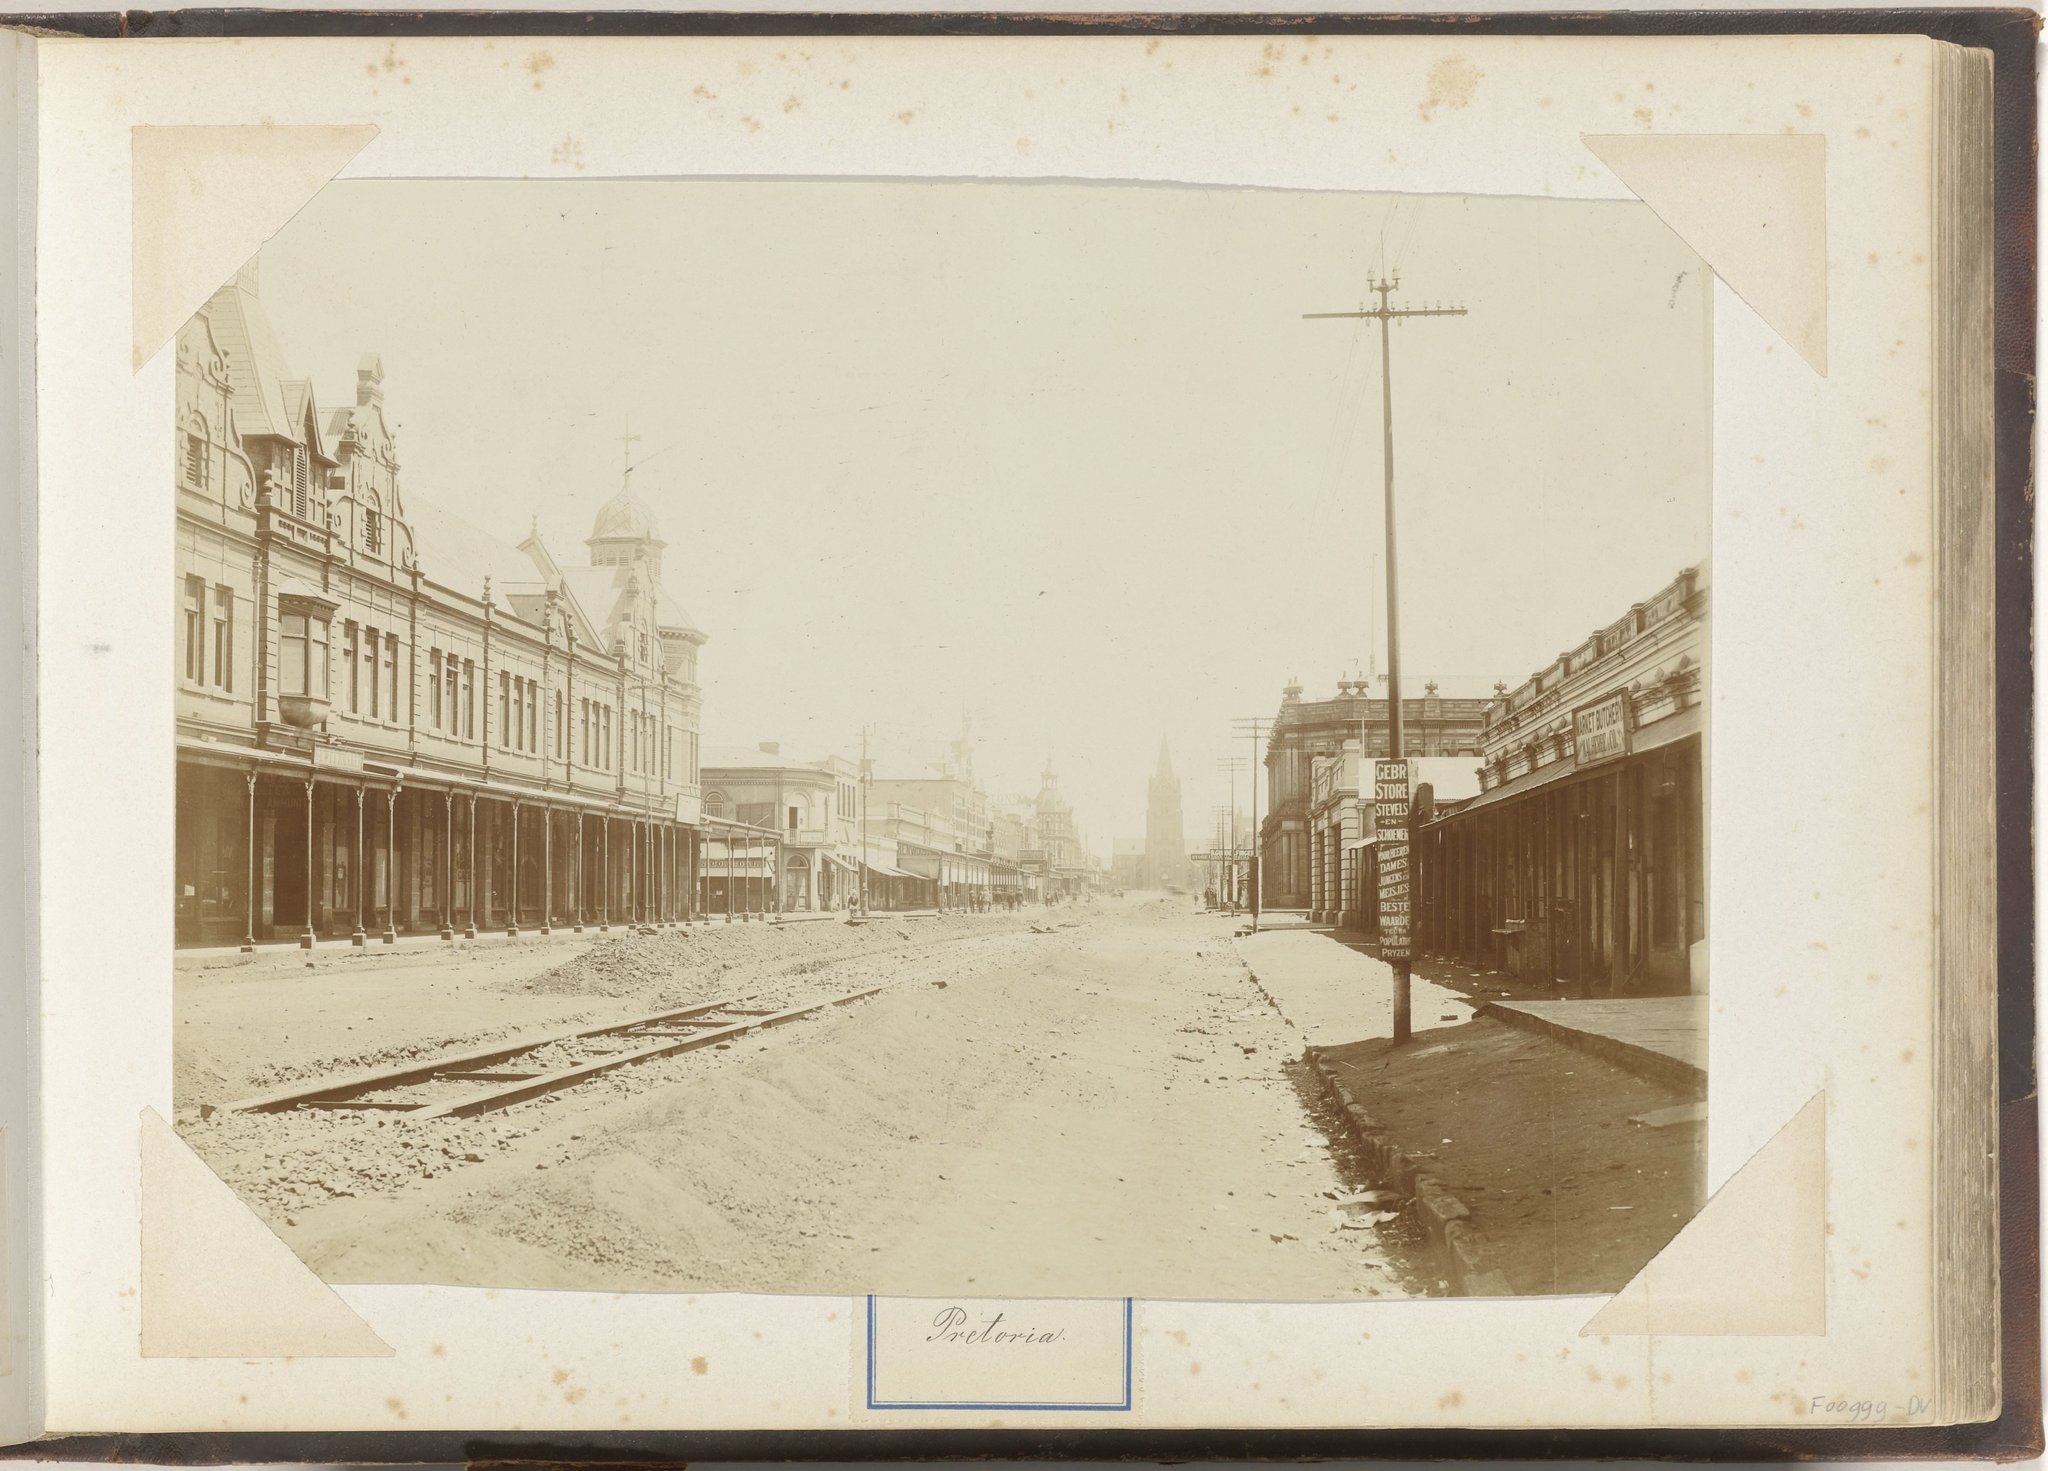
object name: photograph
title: Pretoria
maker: Anonymous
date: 1890-1920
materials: paper, photographic support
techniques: gelatin silver print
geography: pretoria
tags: street (+ city(-scape) with figures, staffage)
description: Onderdeel van Album met 191 foto's van een reis naar en door Zuid-Afrika.